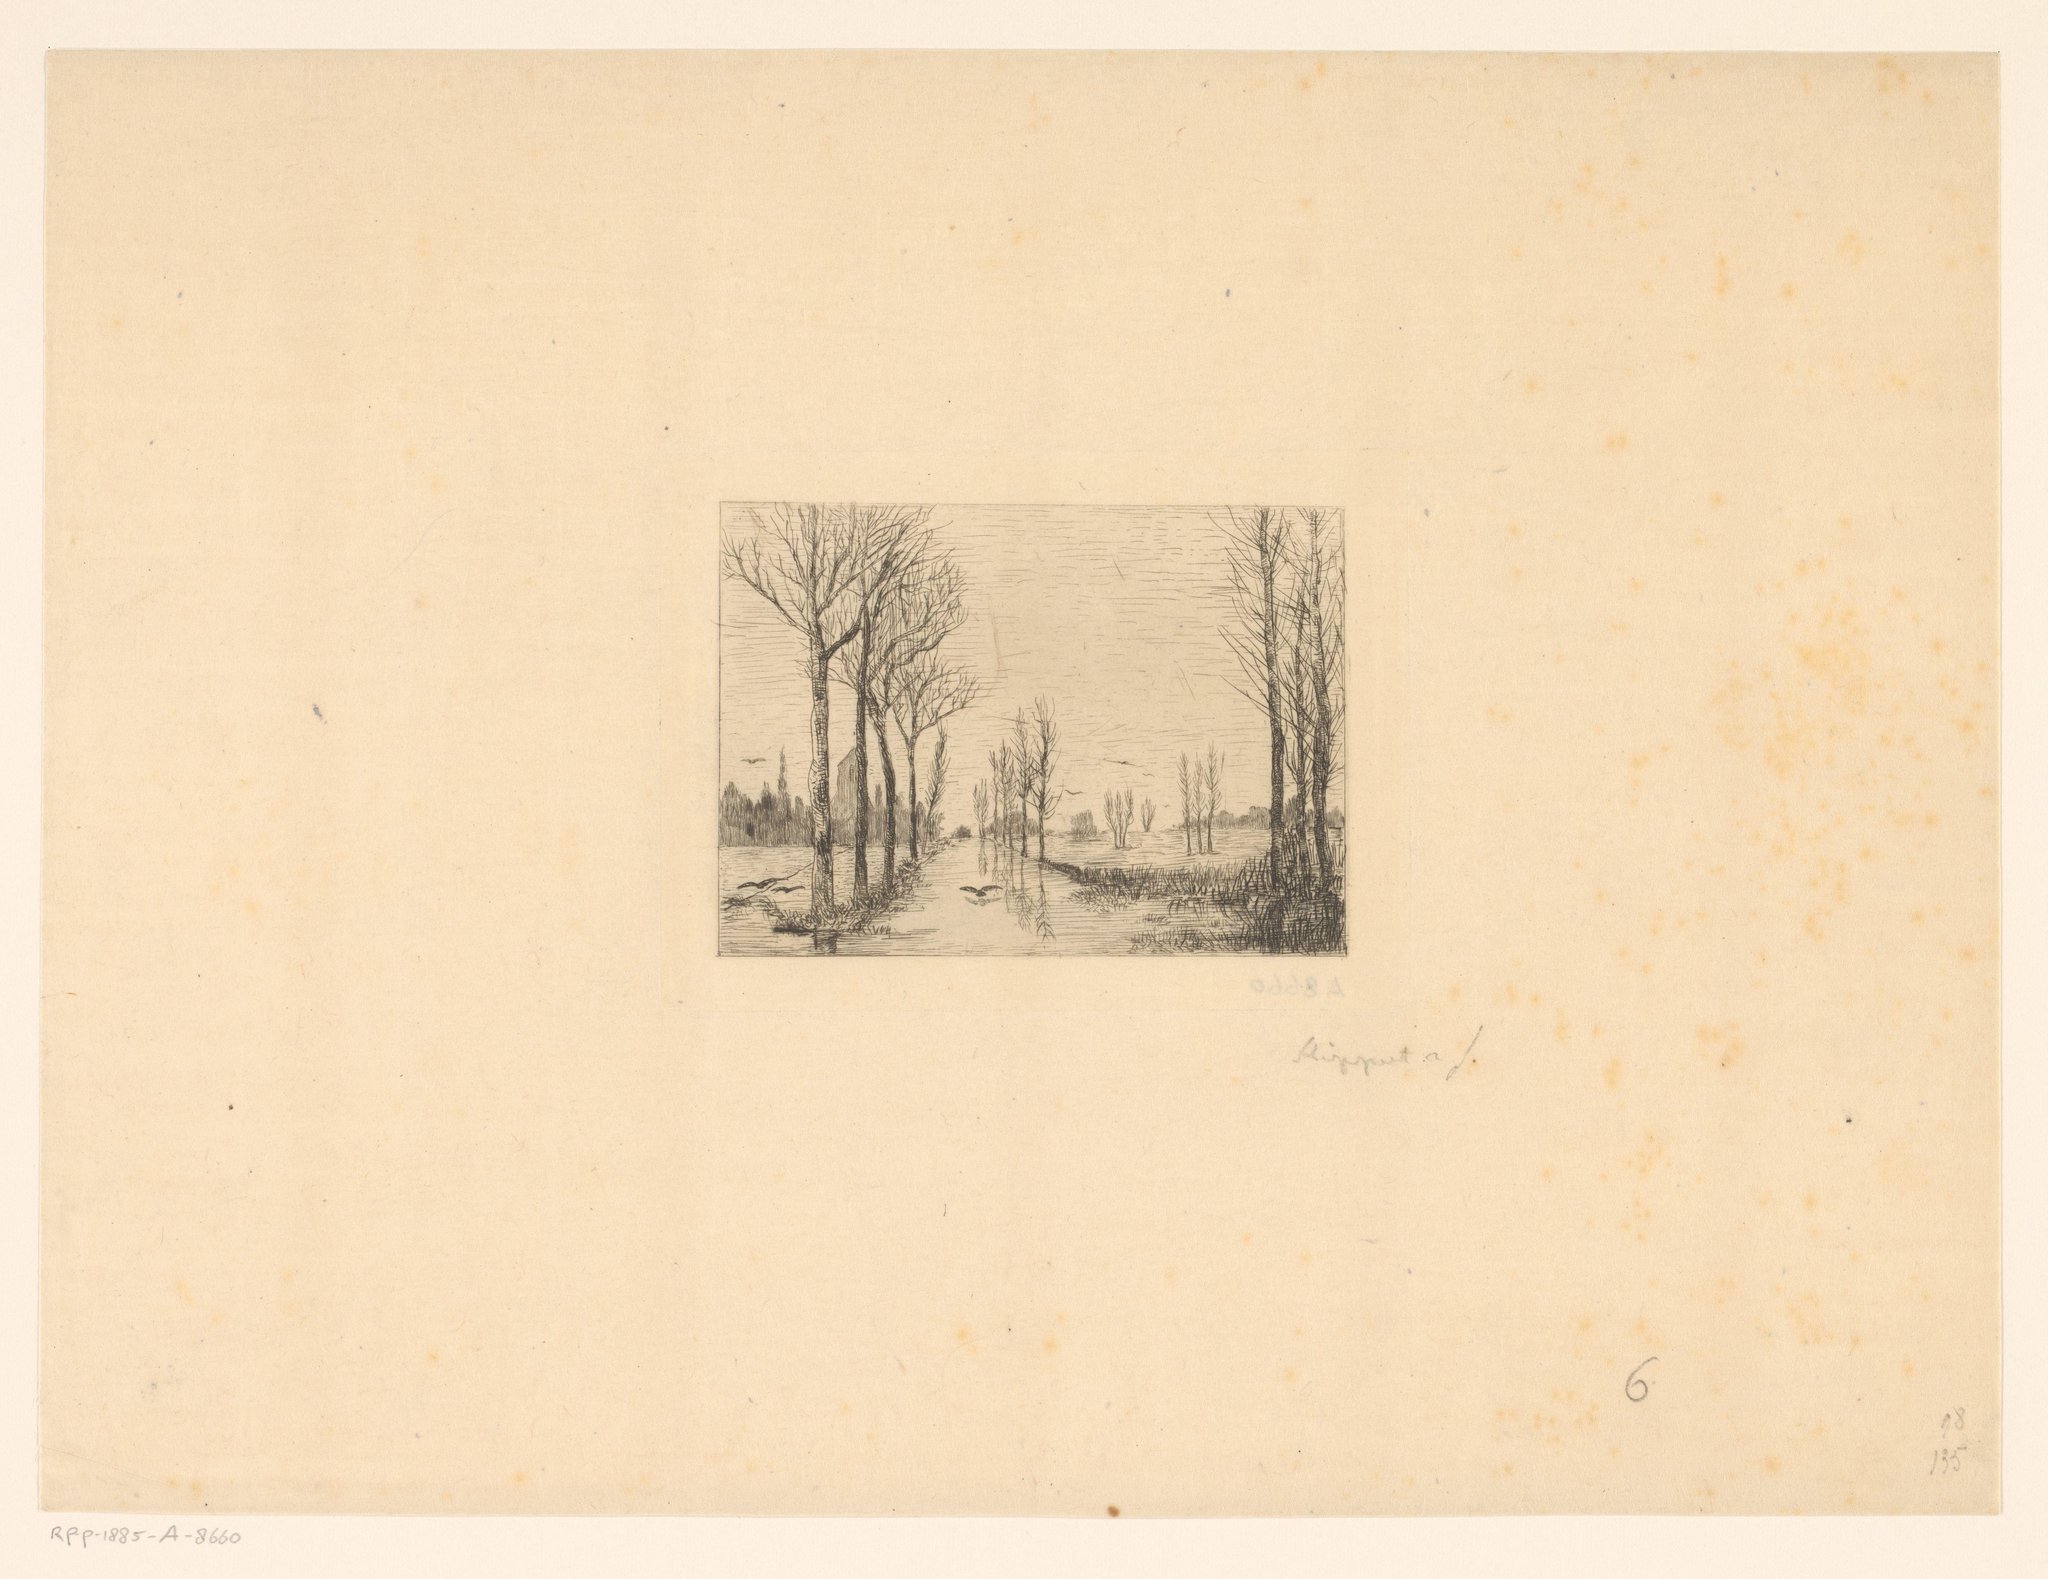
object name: print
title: Landschap met kanaal waarlangs bomen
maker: karel theodoor hippert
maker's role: print maker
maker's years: 1839-1919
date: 1849-1885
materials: paper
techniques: etching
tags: canal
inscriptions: collector's mark: Lugt 2228